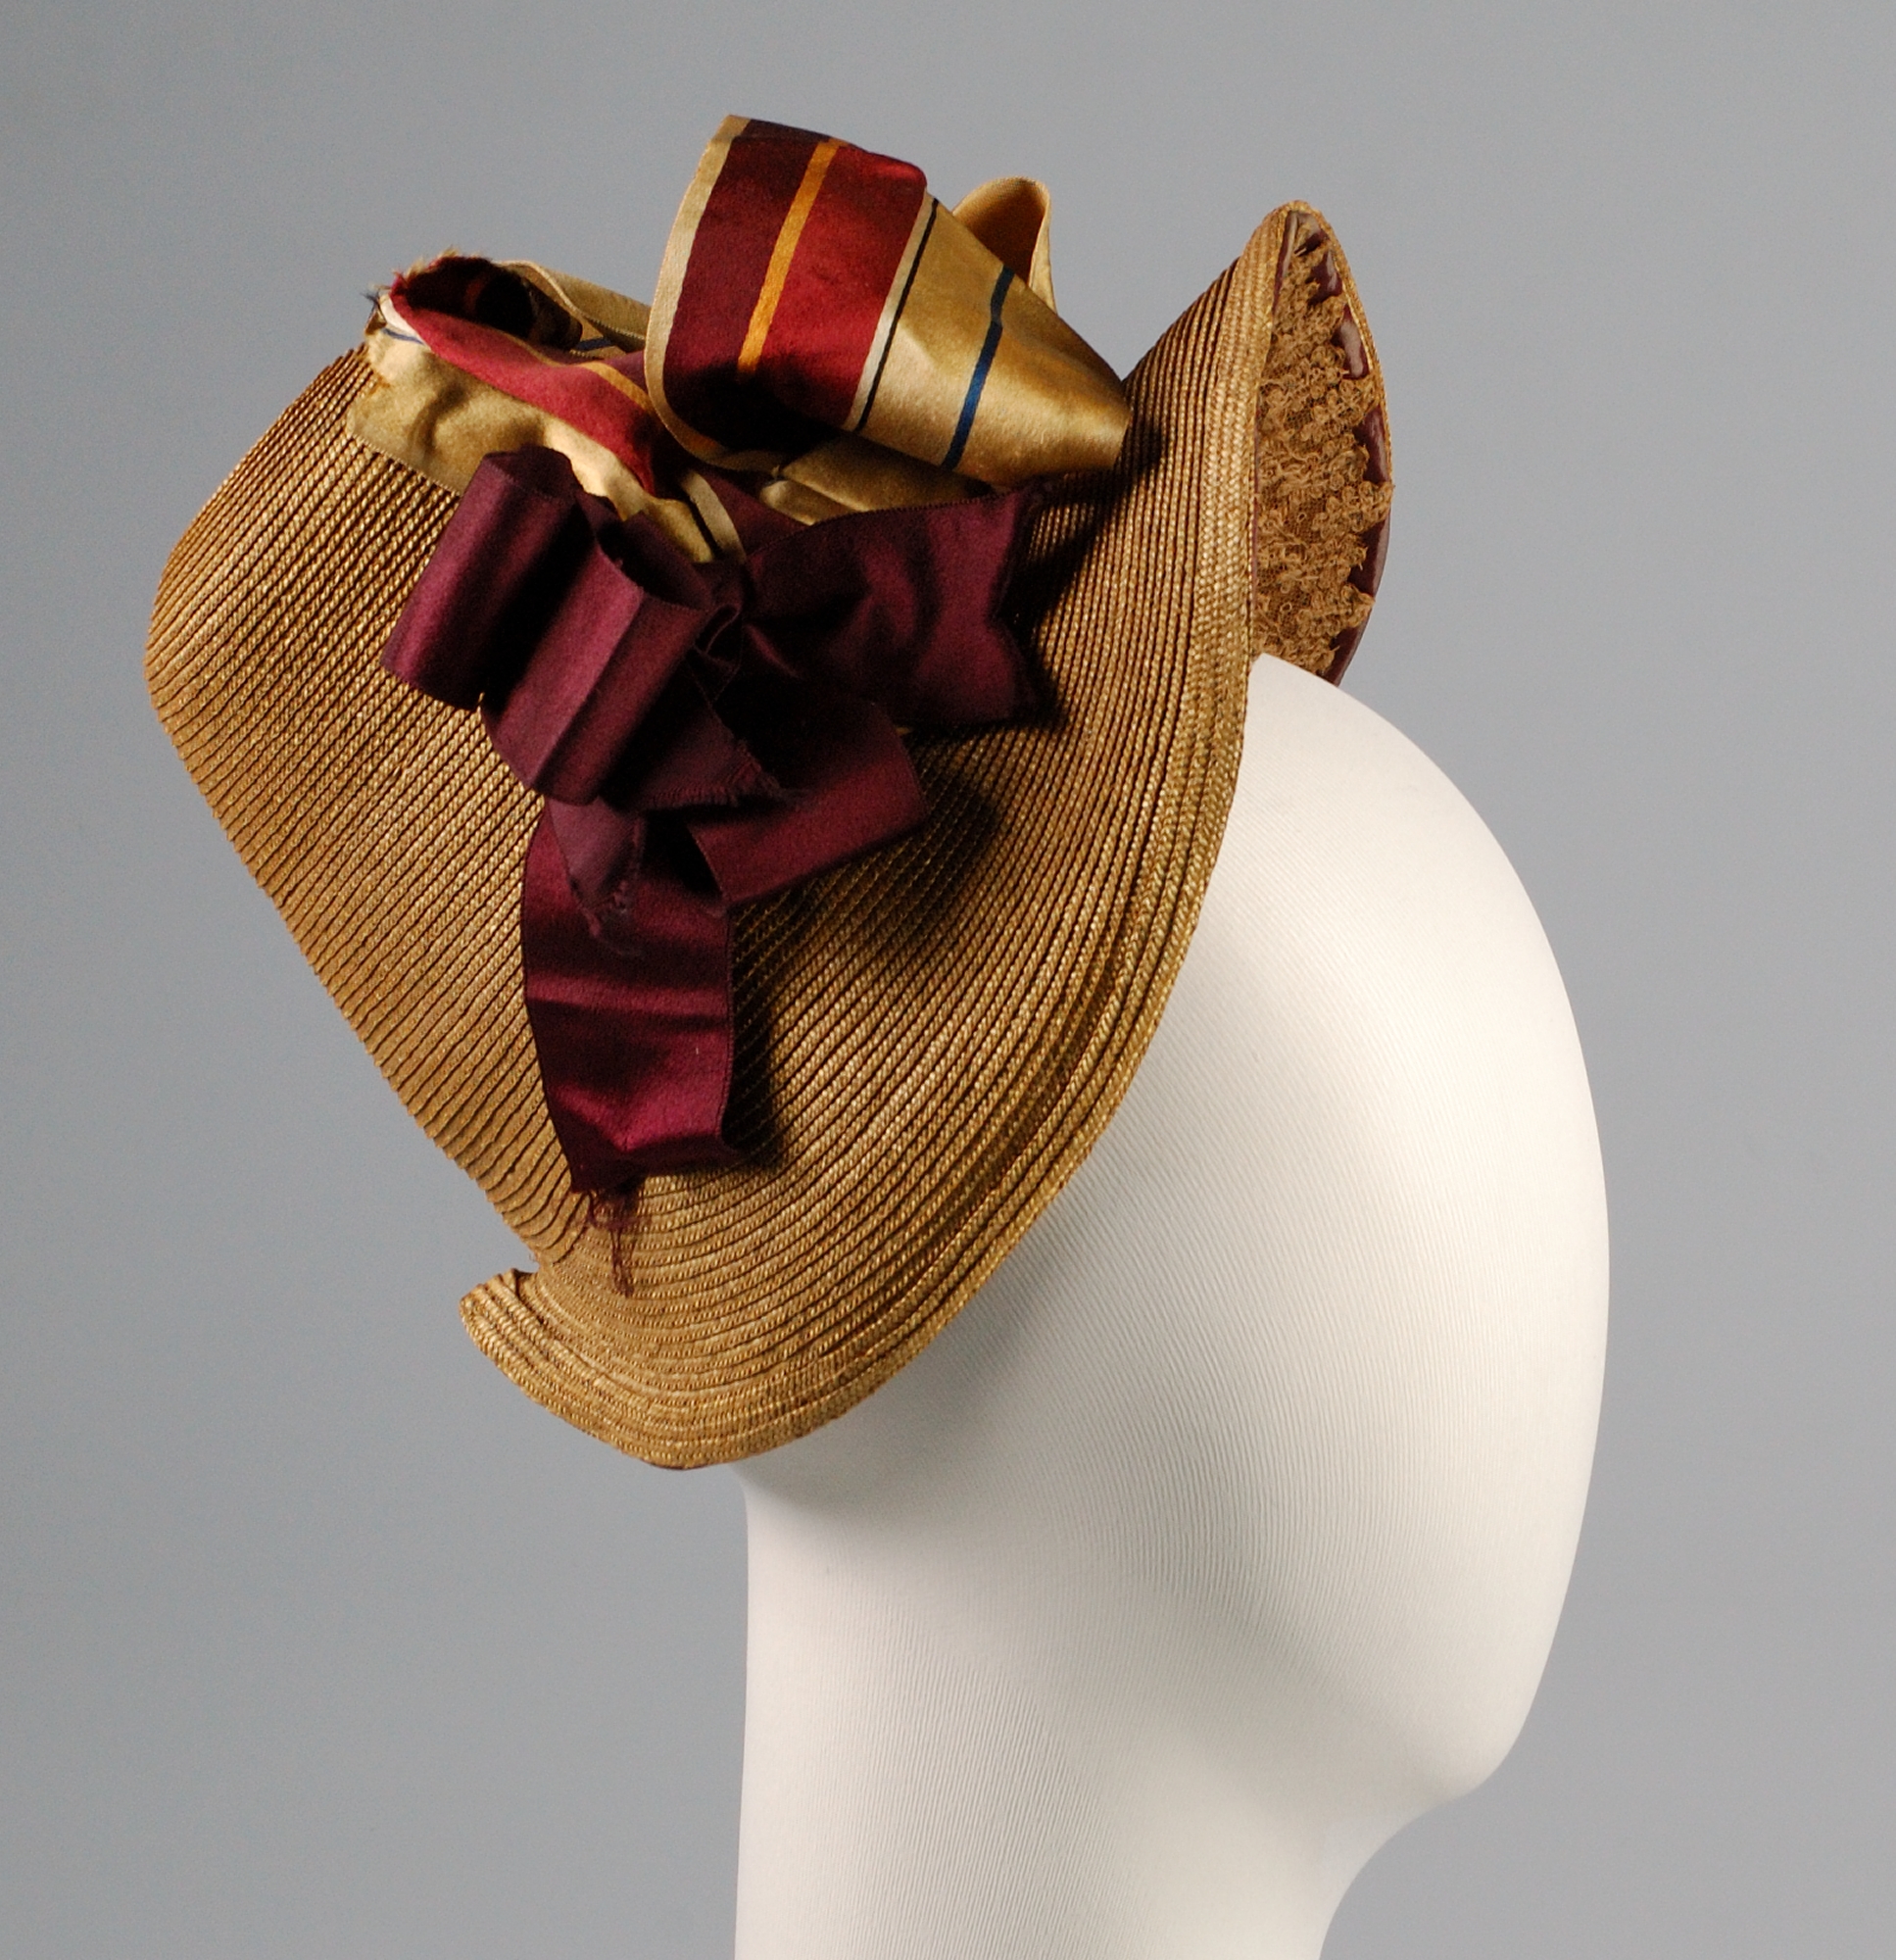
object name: hat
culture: american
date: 1883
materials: linen, silk, fiber